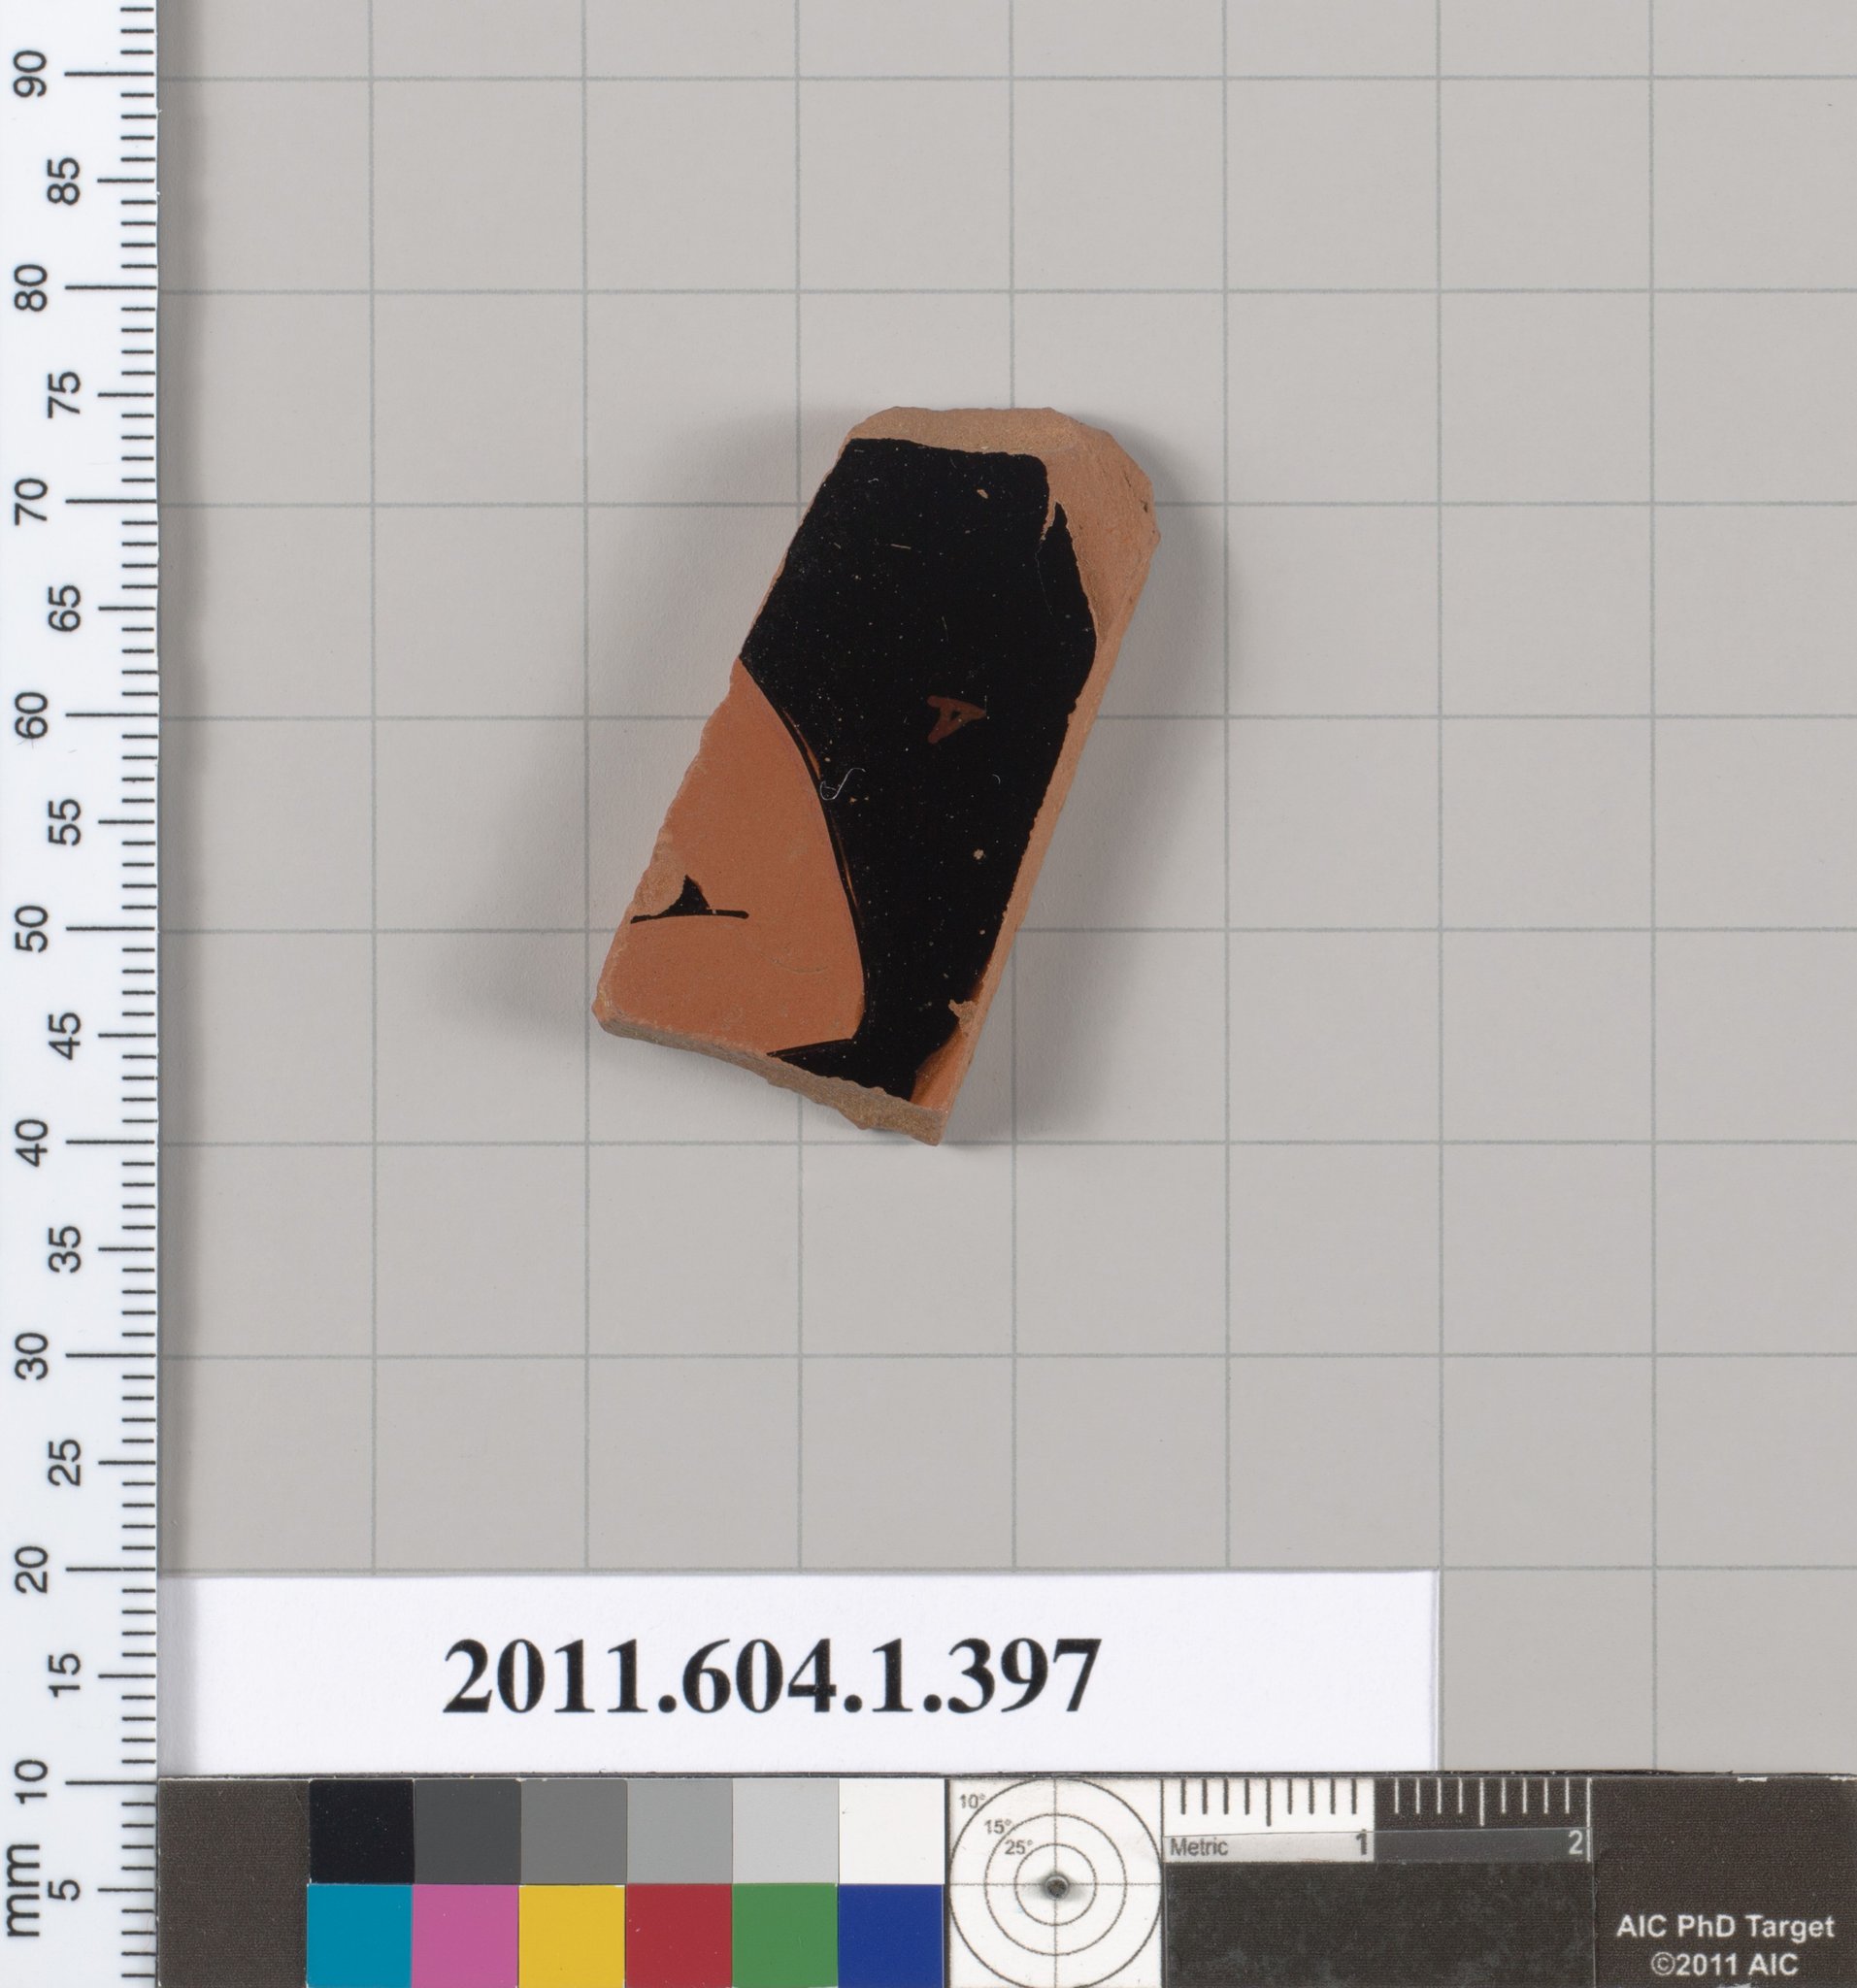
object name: kylix fragment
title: Terracotta fragment of a kylix (drinking cup)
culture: greek, attic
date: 480-470 BCE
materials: terracotta